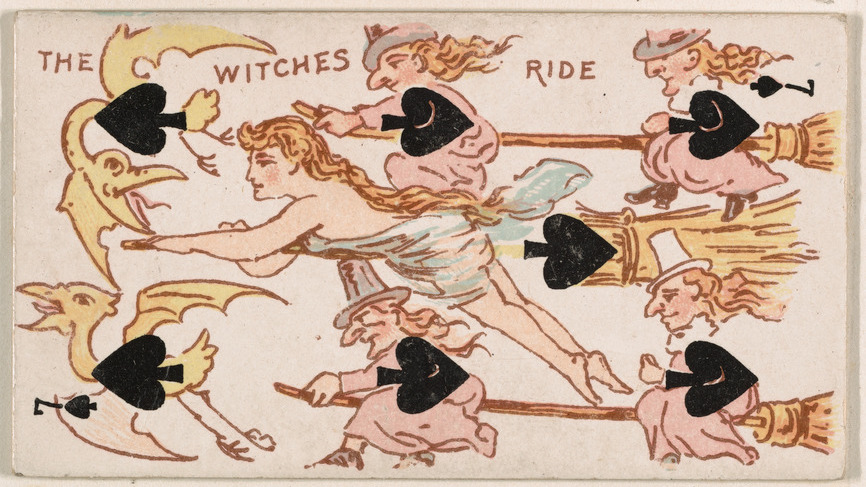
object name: print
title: Seven of Spades, The Witches Ride, from Harlequin Cards, 2nd Series (N220) issued by Kinney Bros.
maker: kinney brothers tobacco company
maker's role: publisher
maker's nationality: american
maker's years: 1869-2011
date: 1889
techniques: color lithograph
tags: playing cards